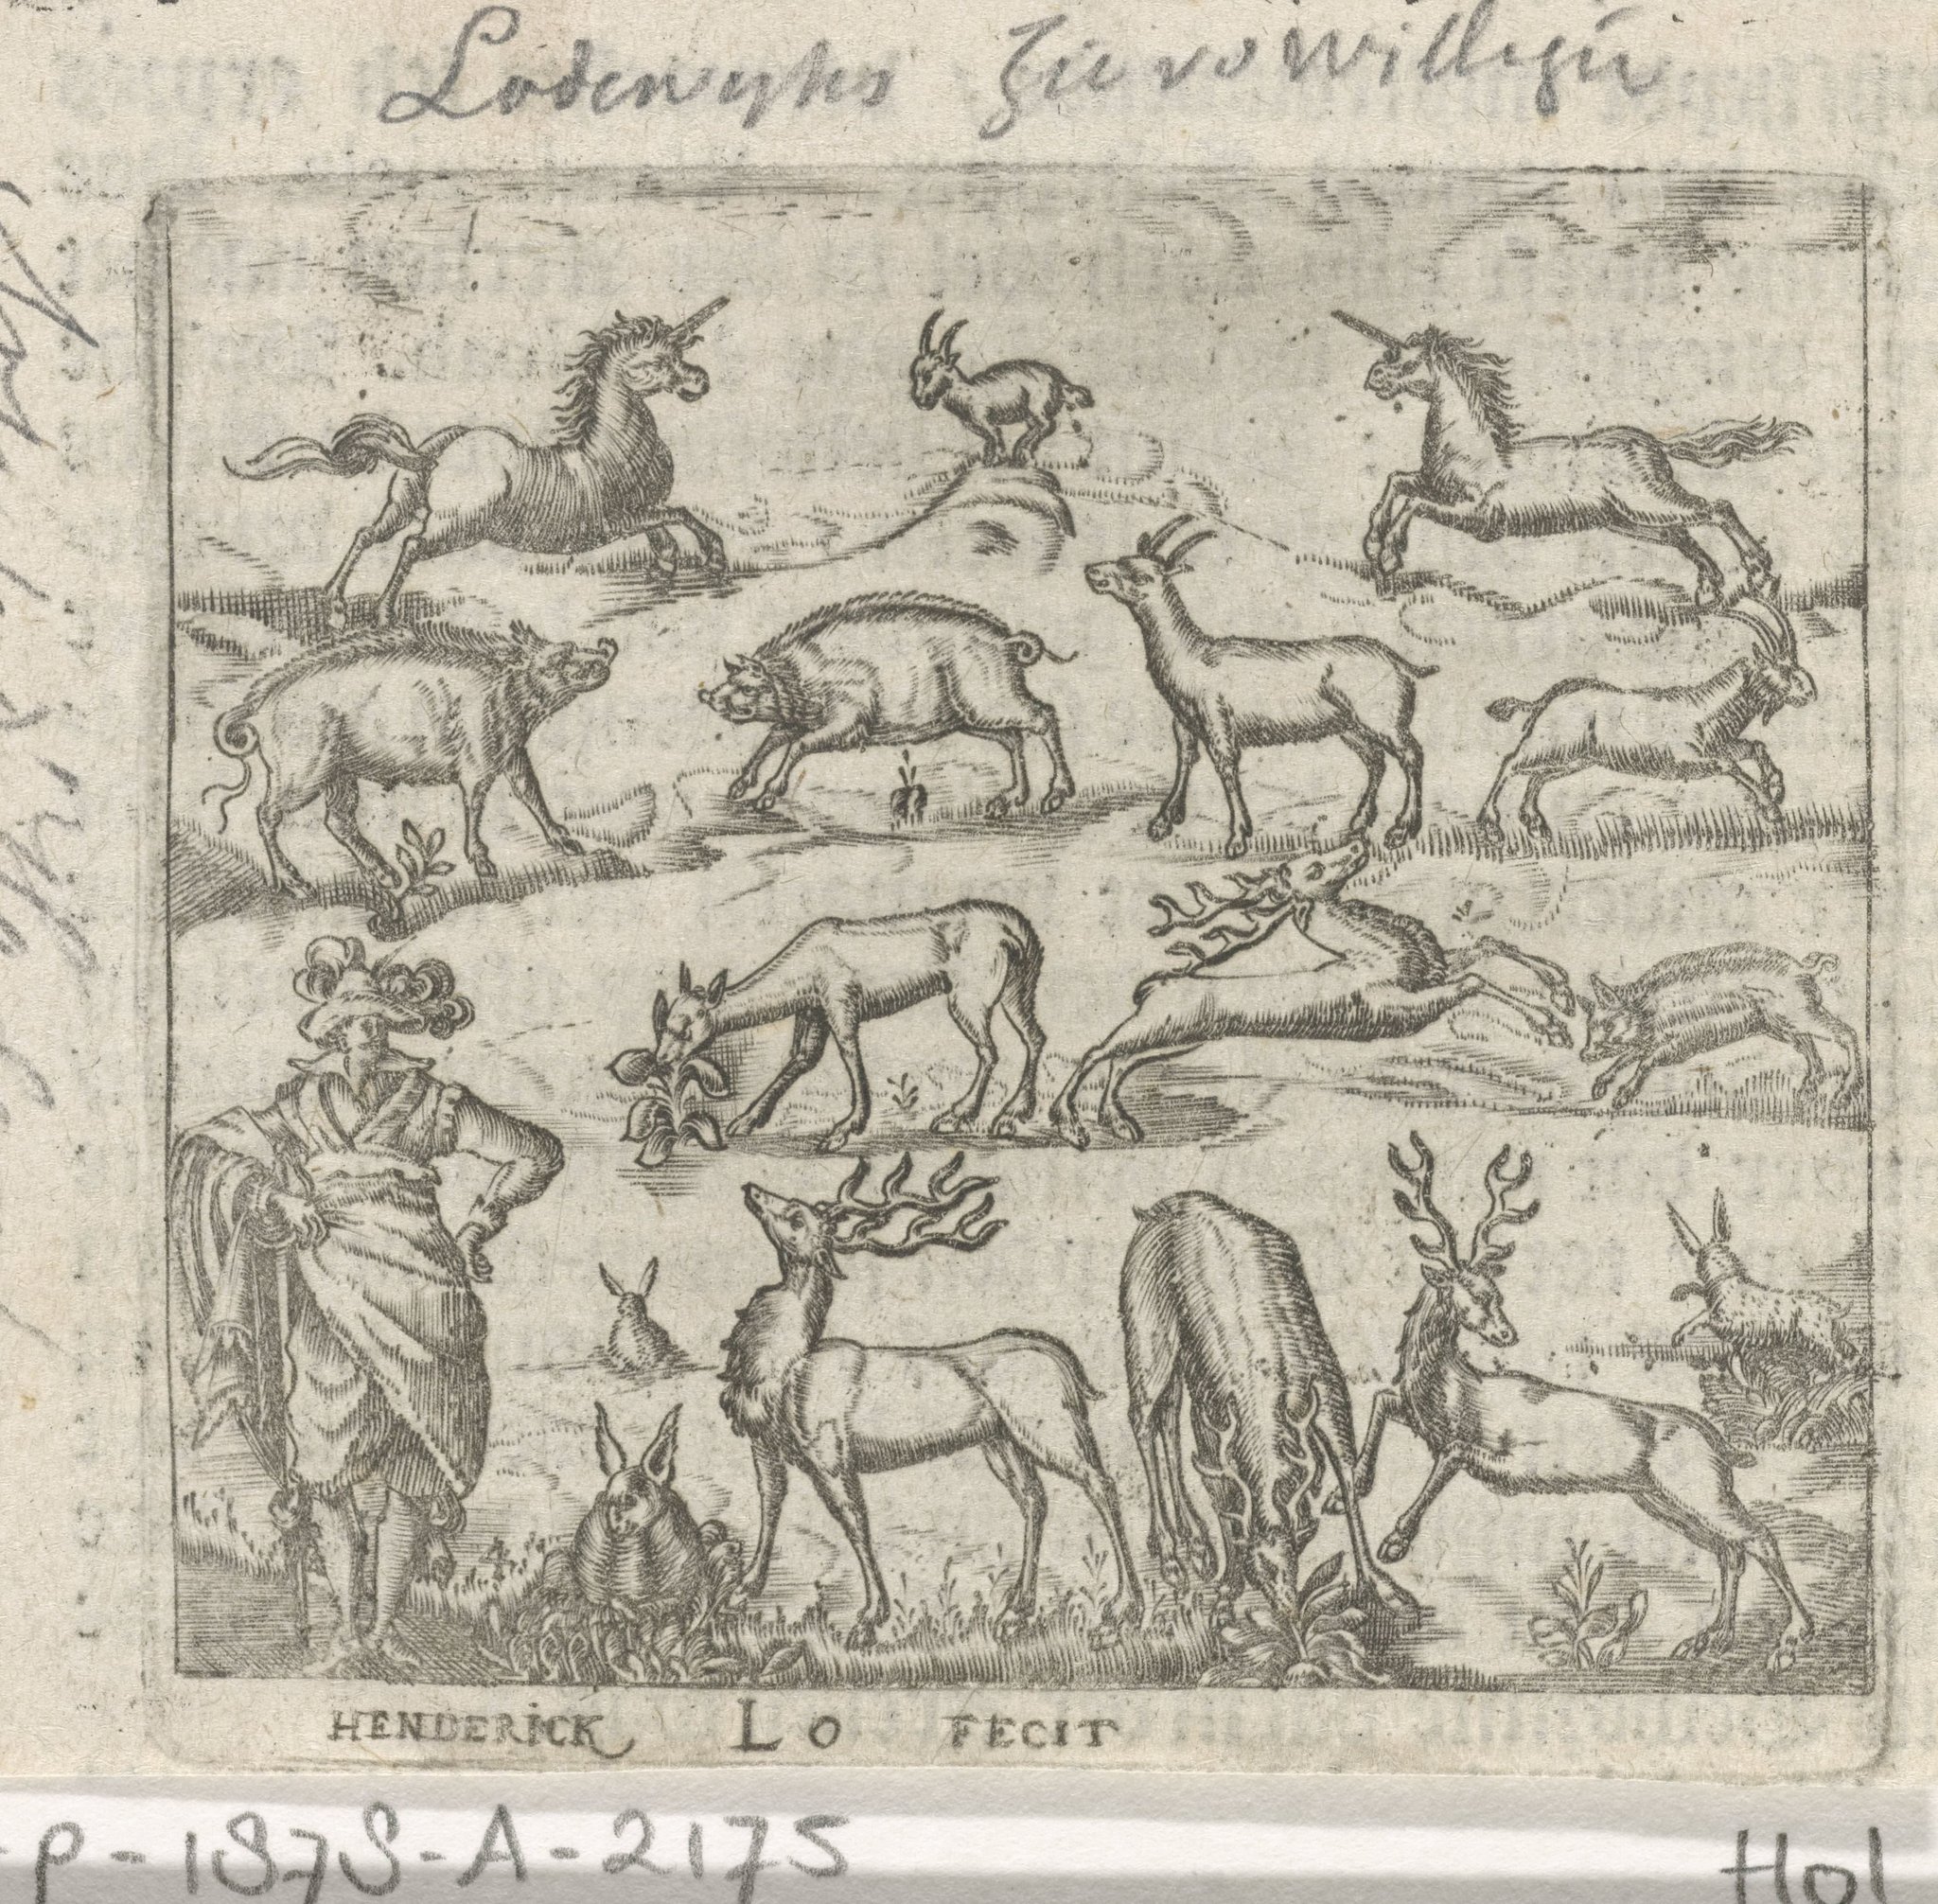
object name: book illustration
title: Verschillende viervoetige dieren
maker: hendrick lodewyck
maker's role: print maker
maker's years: -1652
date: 1626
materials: paper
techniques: etching, letterpress printing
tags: groups of animals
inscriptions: collector's mark: Lugt 2228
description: Verschillende viervoetige dieren, links een man in een zeventiende-eeuws kostuum. Prent links- en rechtsboven gemerkt: 124 - Gen. 8.